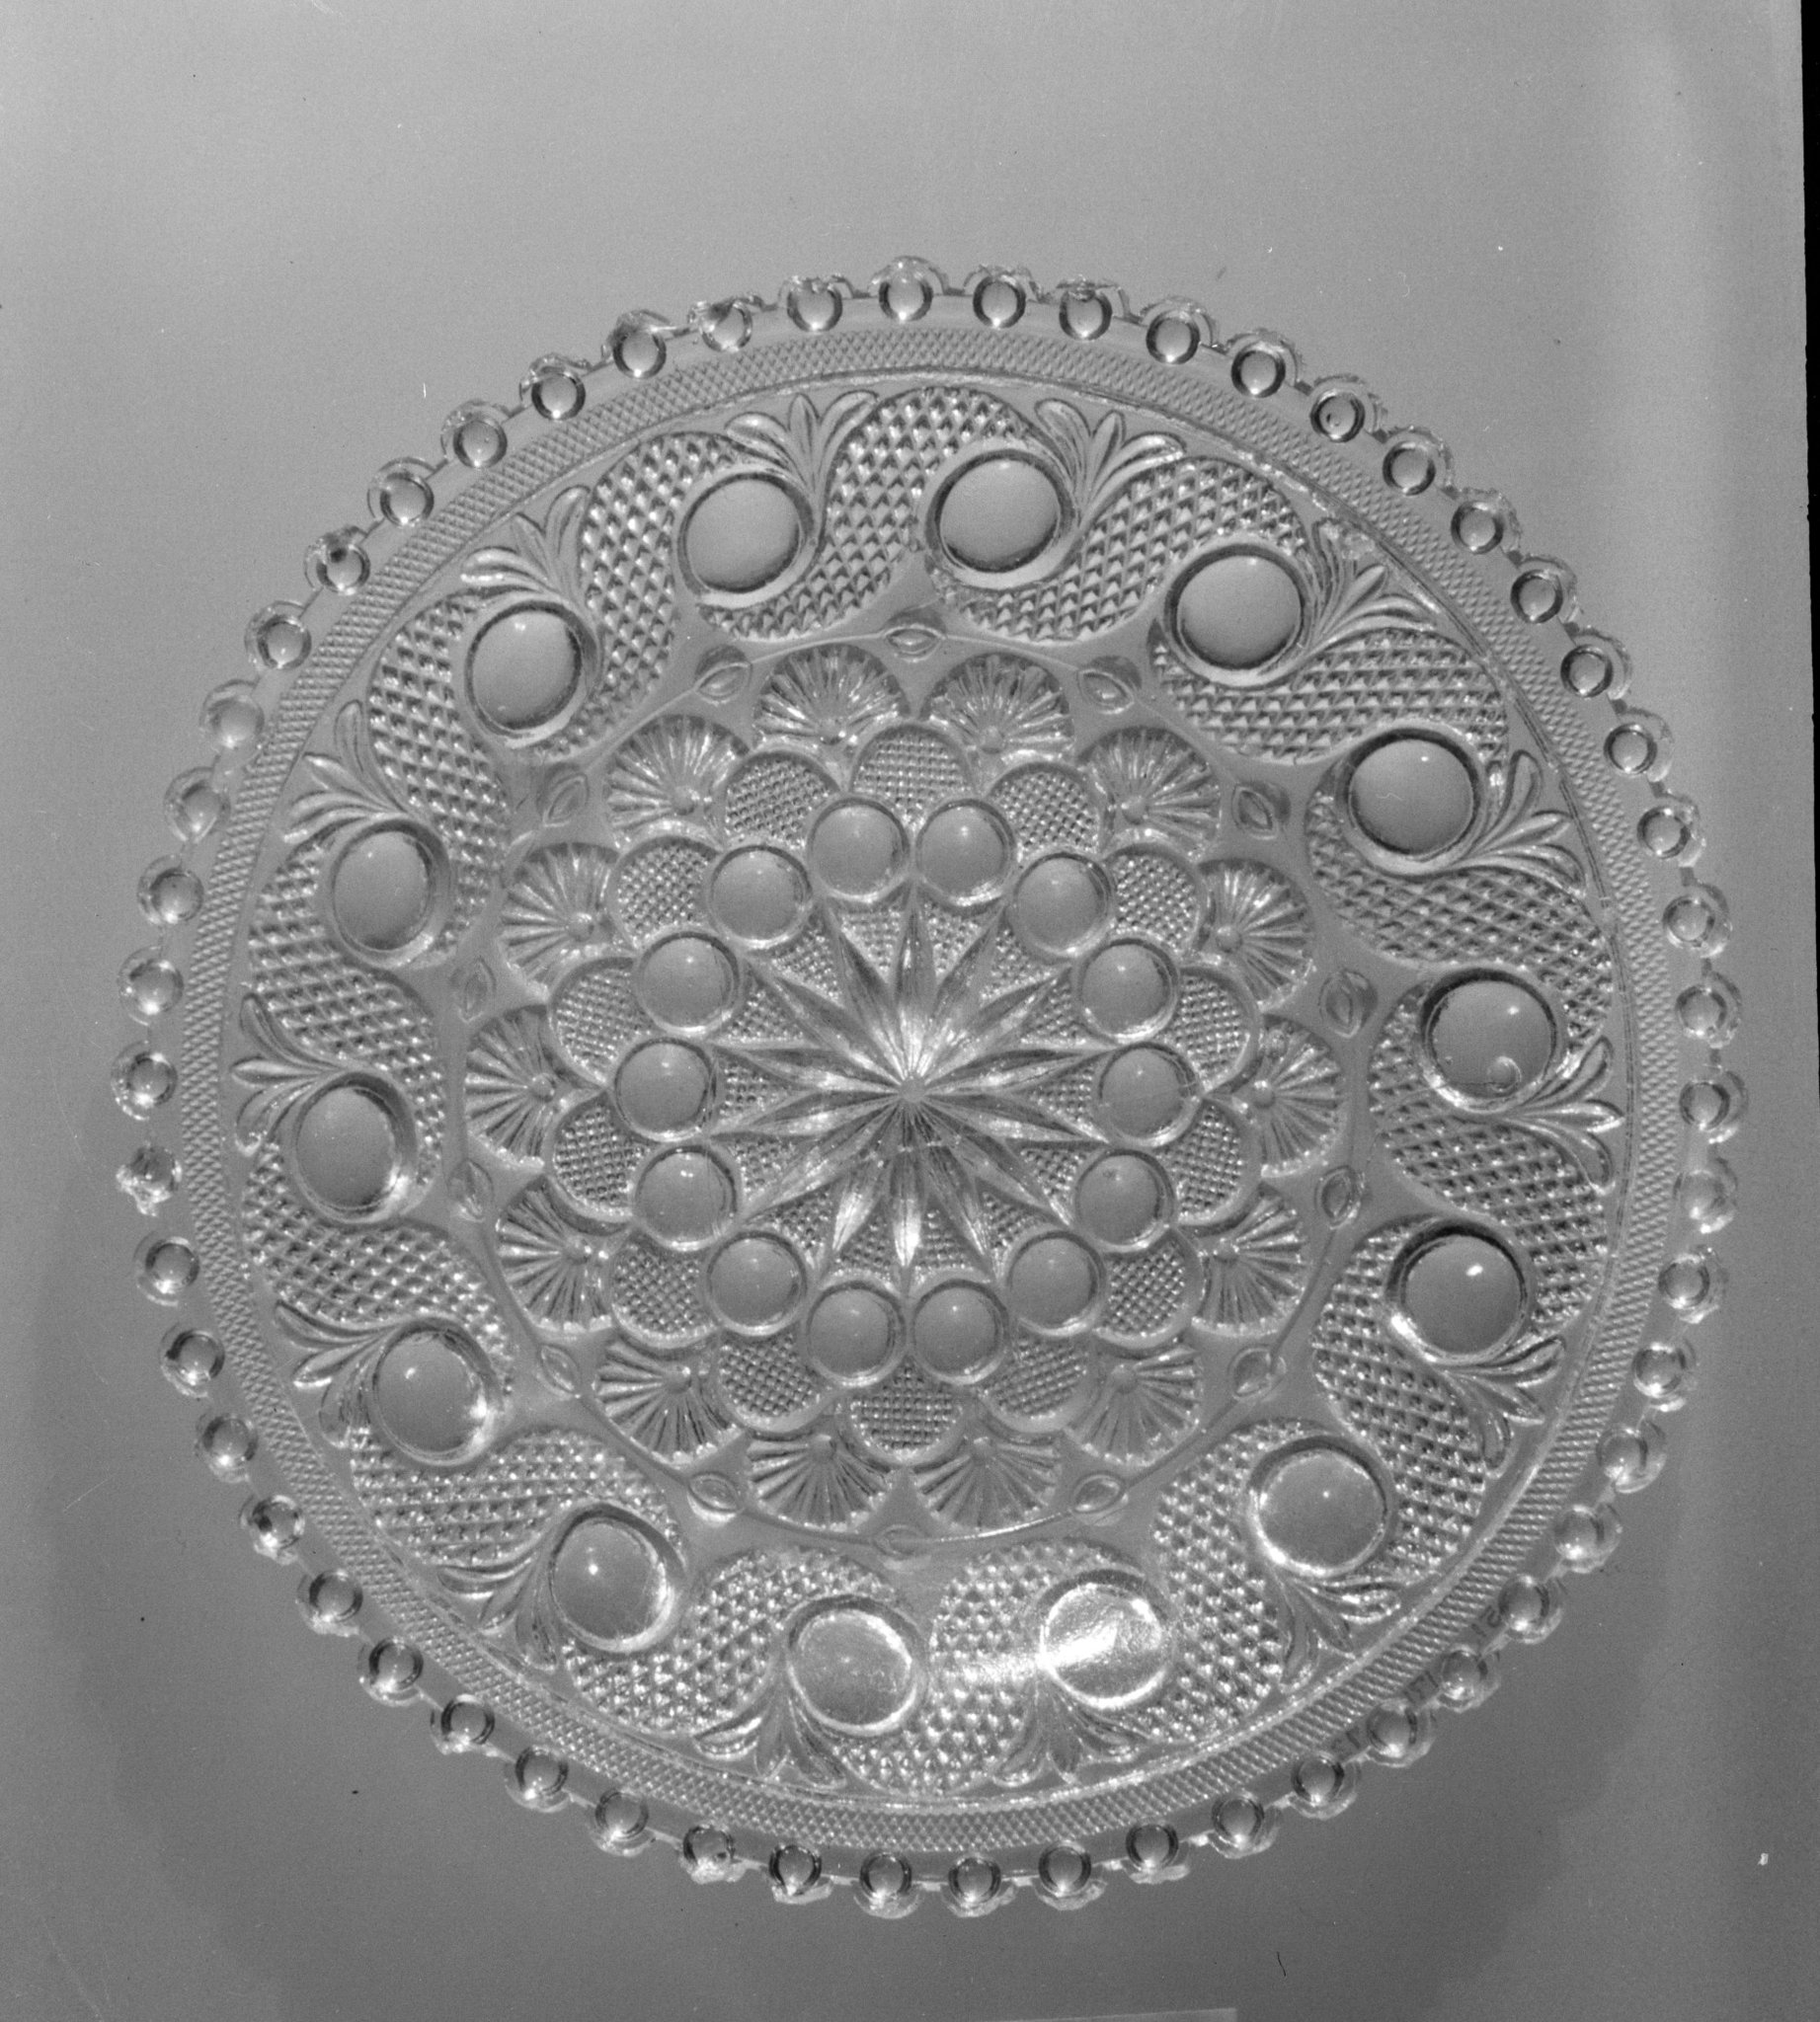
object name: dish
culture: american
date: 1835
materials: glass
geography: united states